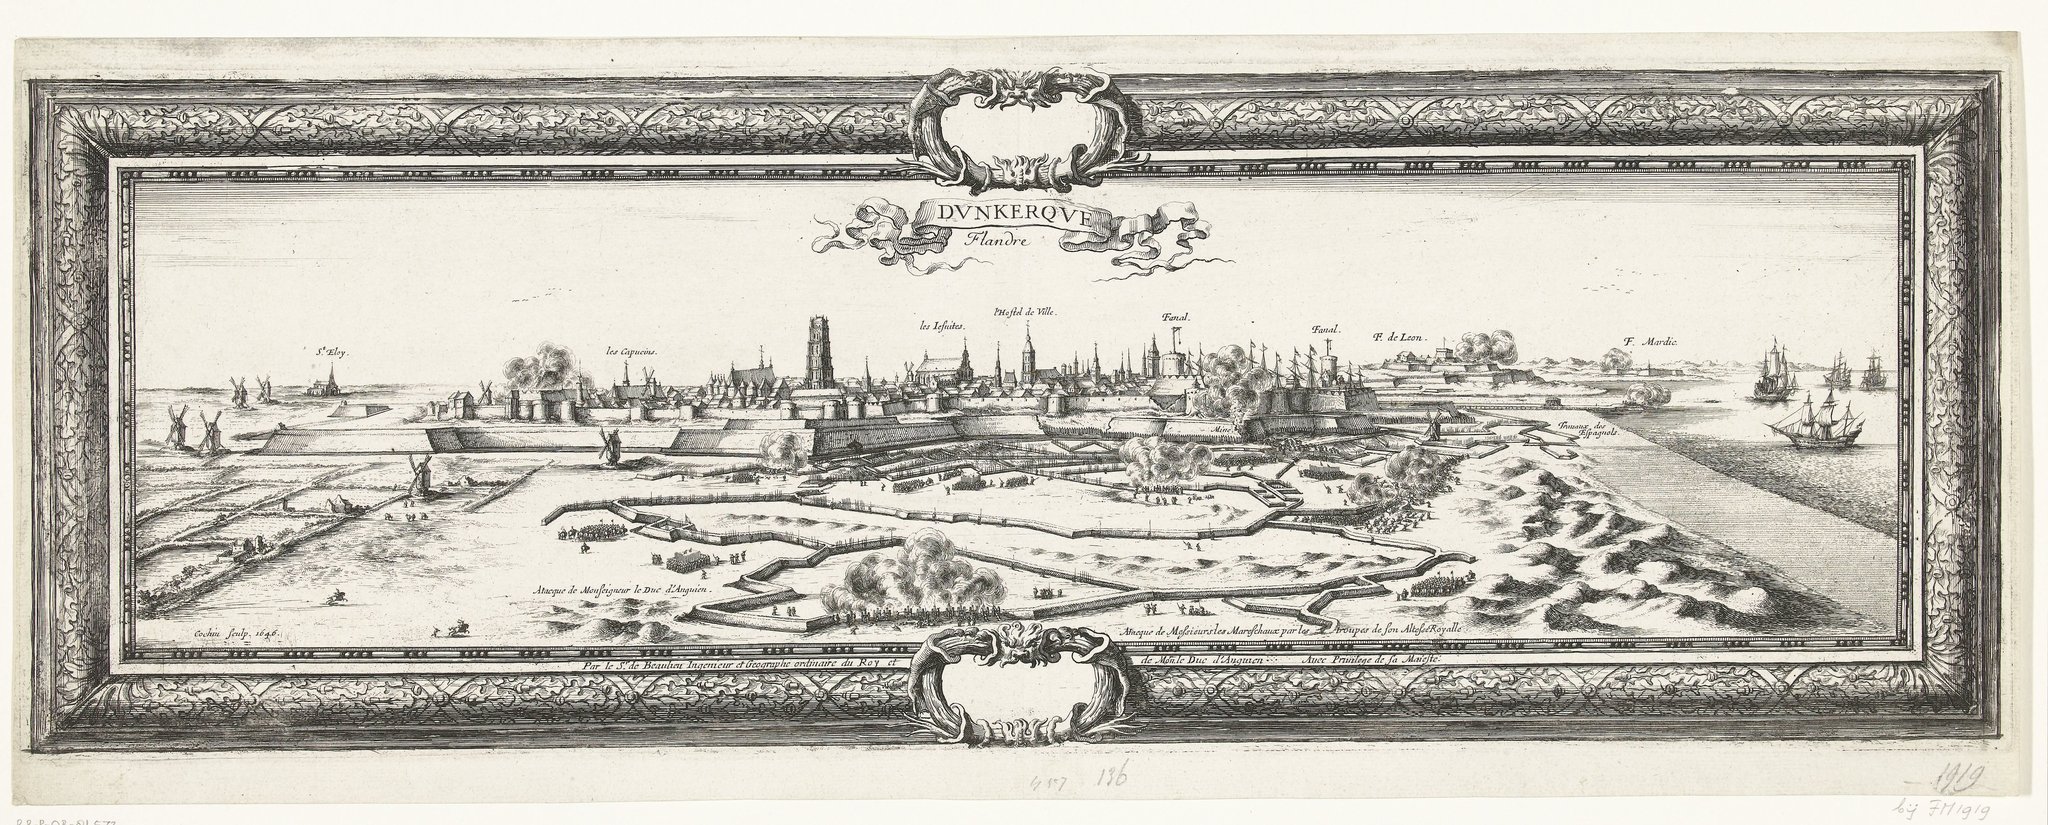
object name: print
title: Les Glorieuses conquêtes de Louis le Grand, d'après le chevalier de Beaulieu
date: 1646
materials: paper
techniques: etching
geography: france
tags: paris, lodewijk ii de bourbon-condé (hertog van enghien), brielle, maarten harpertszoon tromp, siege, position war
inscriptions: date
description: Profiel van de stad Duinkerken, belegerd door het Franse leger onder de hertog van Enghien, 1646. Op de voorgrond beschietingen door het Franse leger. In ornamentele omlijsting met twee cartouches. Dit profiel behoort bij een plattegrond van de stad. Onderdeel van een serie voorstellingen van de militaire overwinningen behaald door koning Lodewijk XIV.